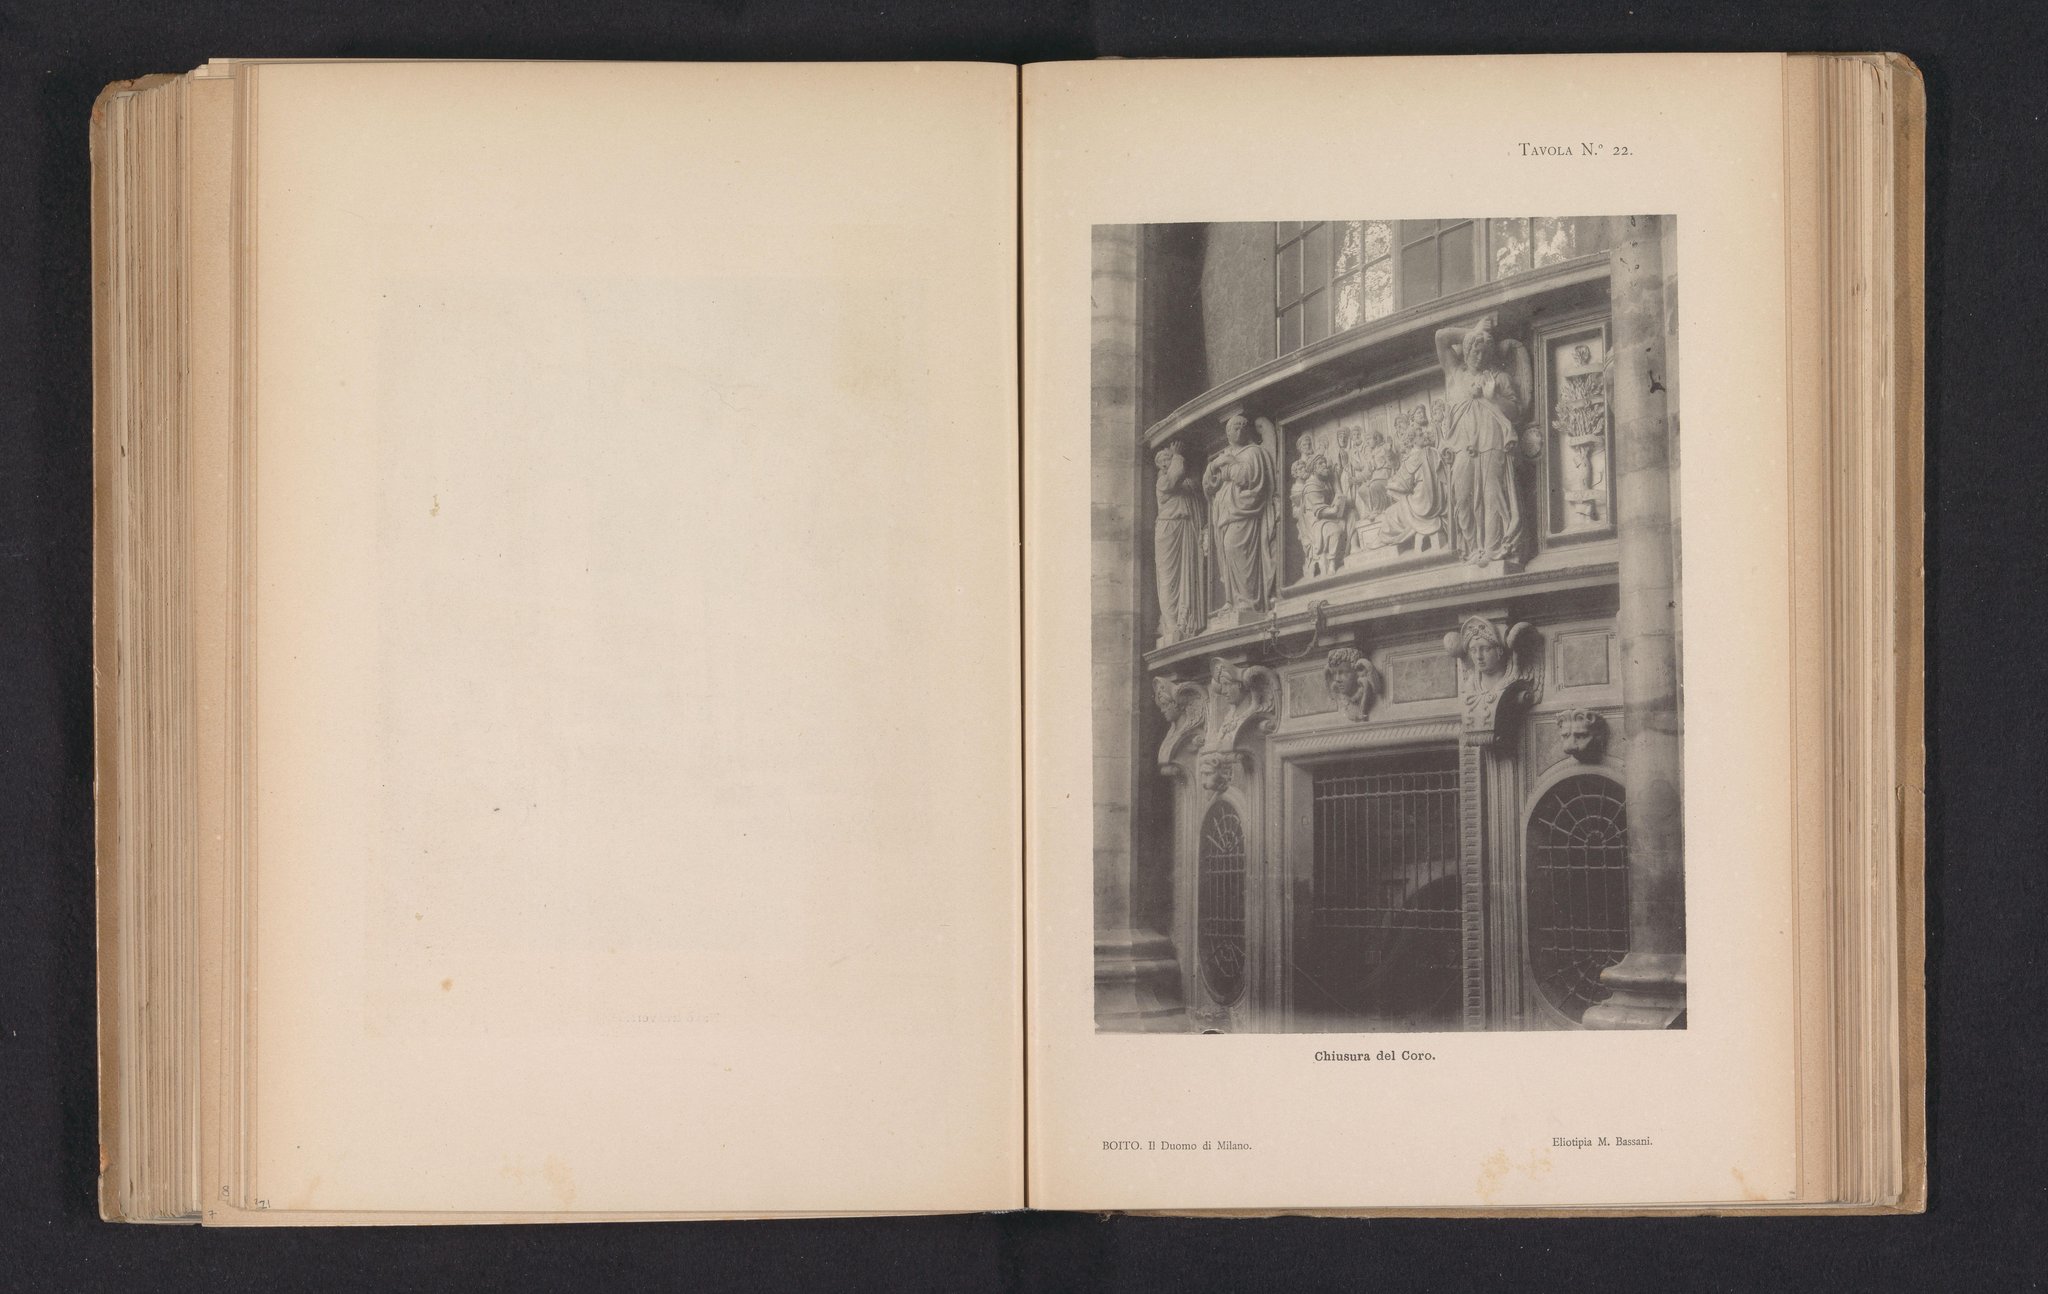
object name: page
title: Koorhek in de Dom van Milaan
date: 1879-1889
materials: paper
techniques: photograph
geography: milan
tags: rood-screen, choir-screen; iconostasis, parts of church interior: choir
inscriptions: number: ‘Tavola No. 22.’